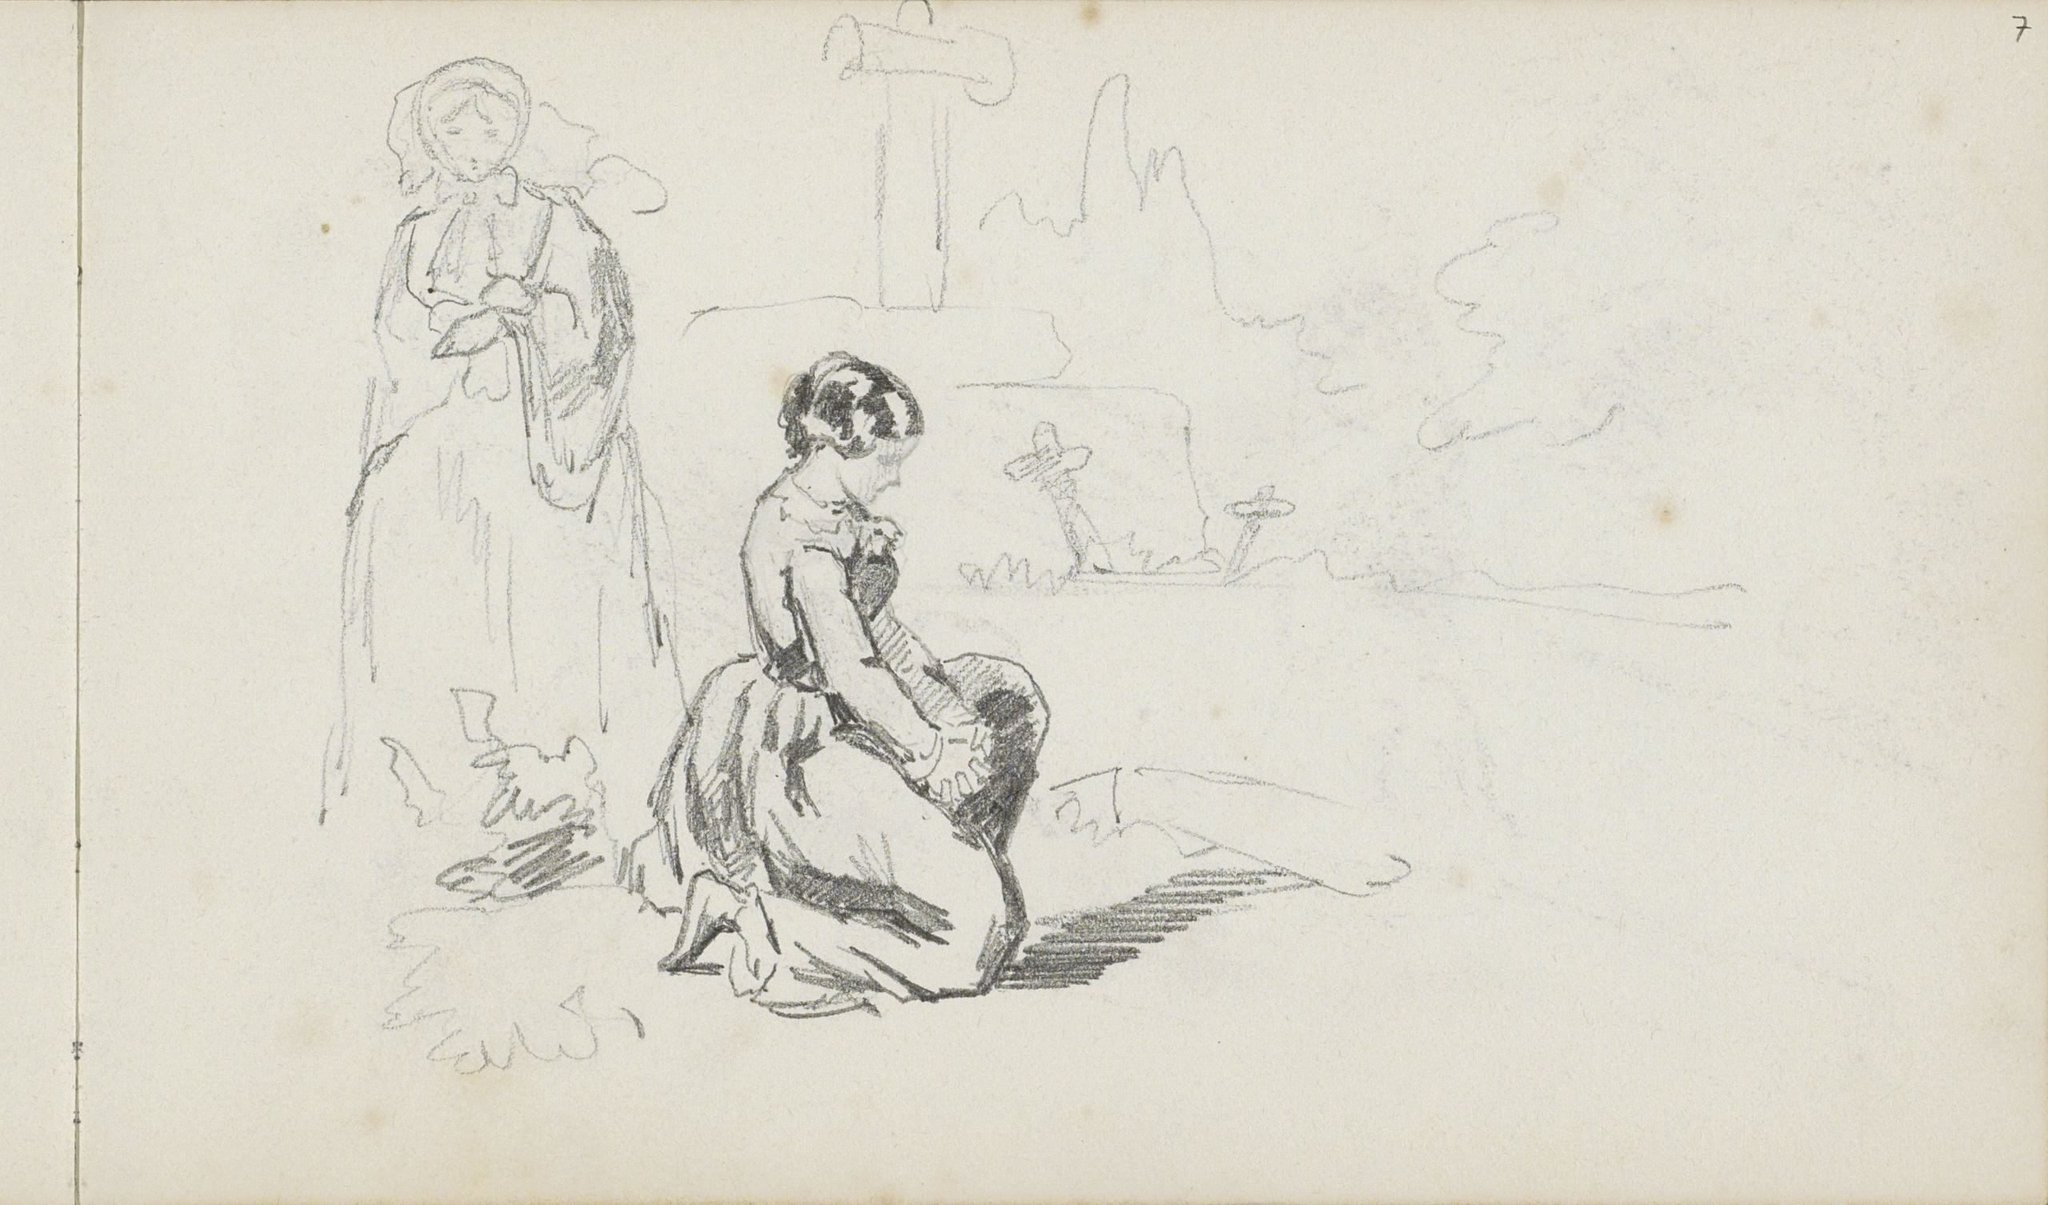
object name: sketchbook leaf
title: Knielend meisje bij een kerkhof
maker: charles rochussen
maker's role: draughtsman, painter, print maker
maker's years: 1814-1894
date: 1840-1860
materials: paper, pencil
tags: kneeling figure - aa - female human figure, churchyard, cemetery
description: Tevens een studie van een vrouw met een omslagdoek en muts. Blad 7 recto uit een schetsboek met 38 bladen.